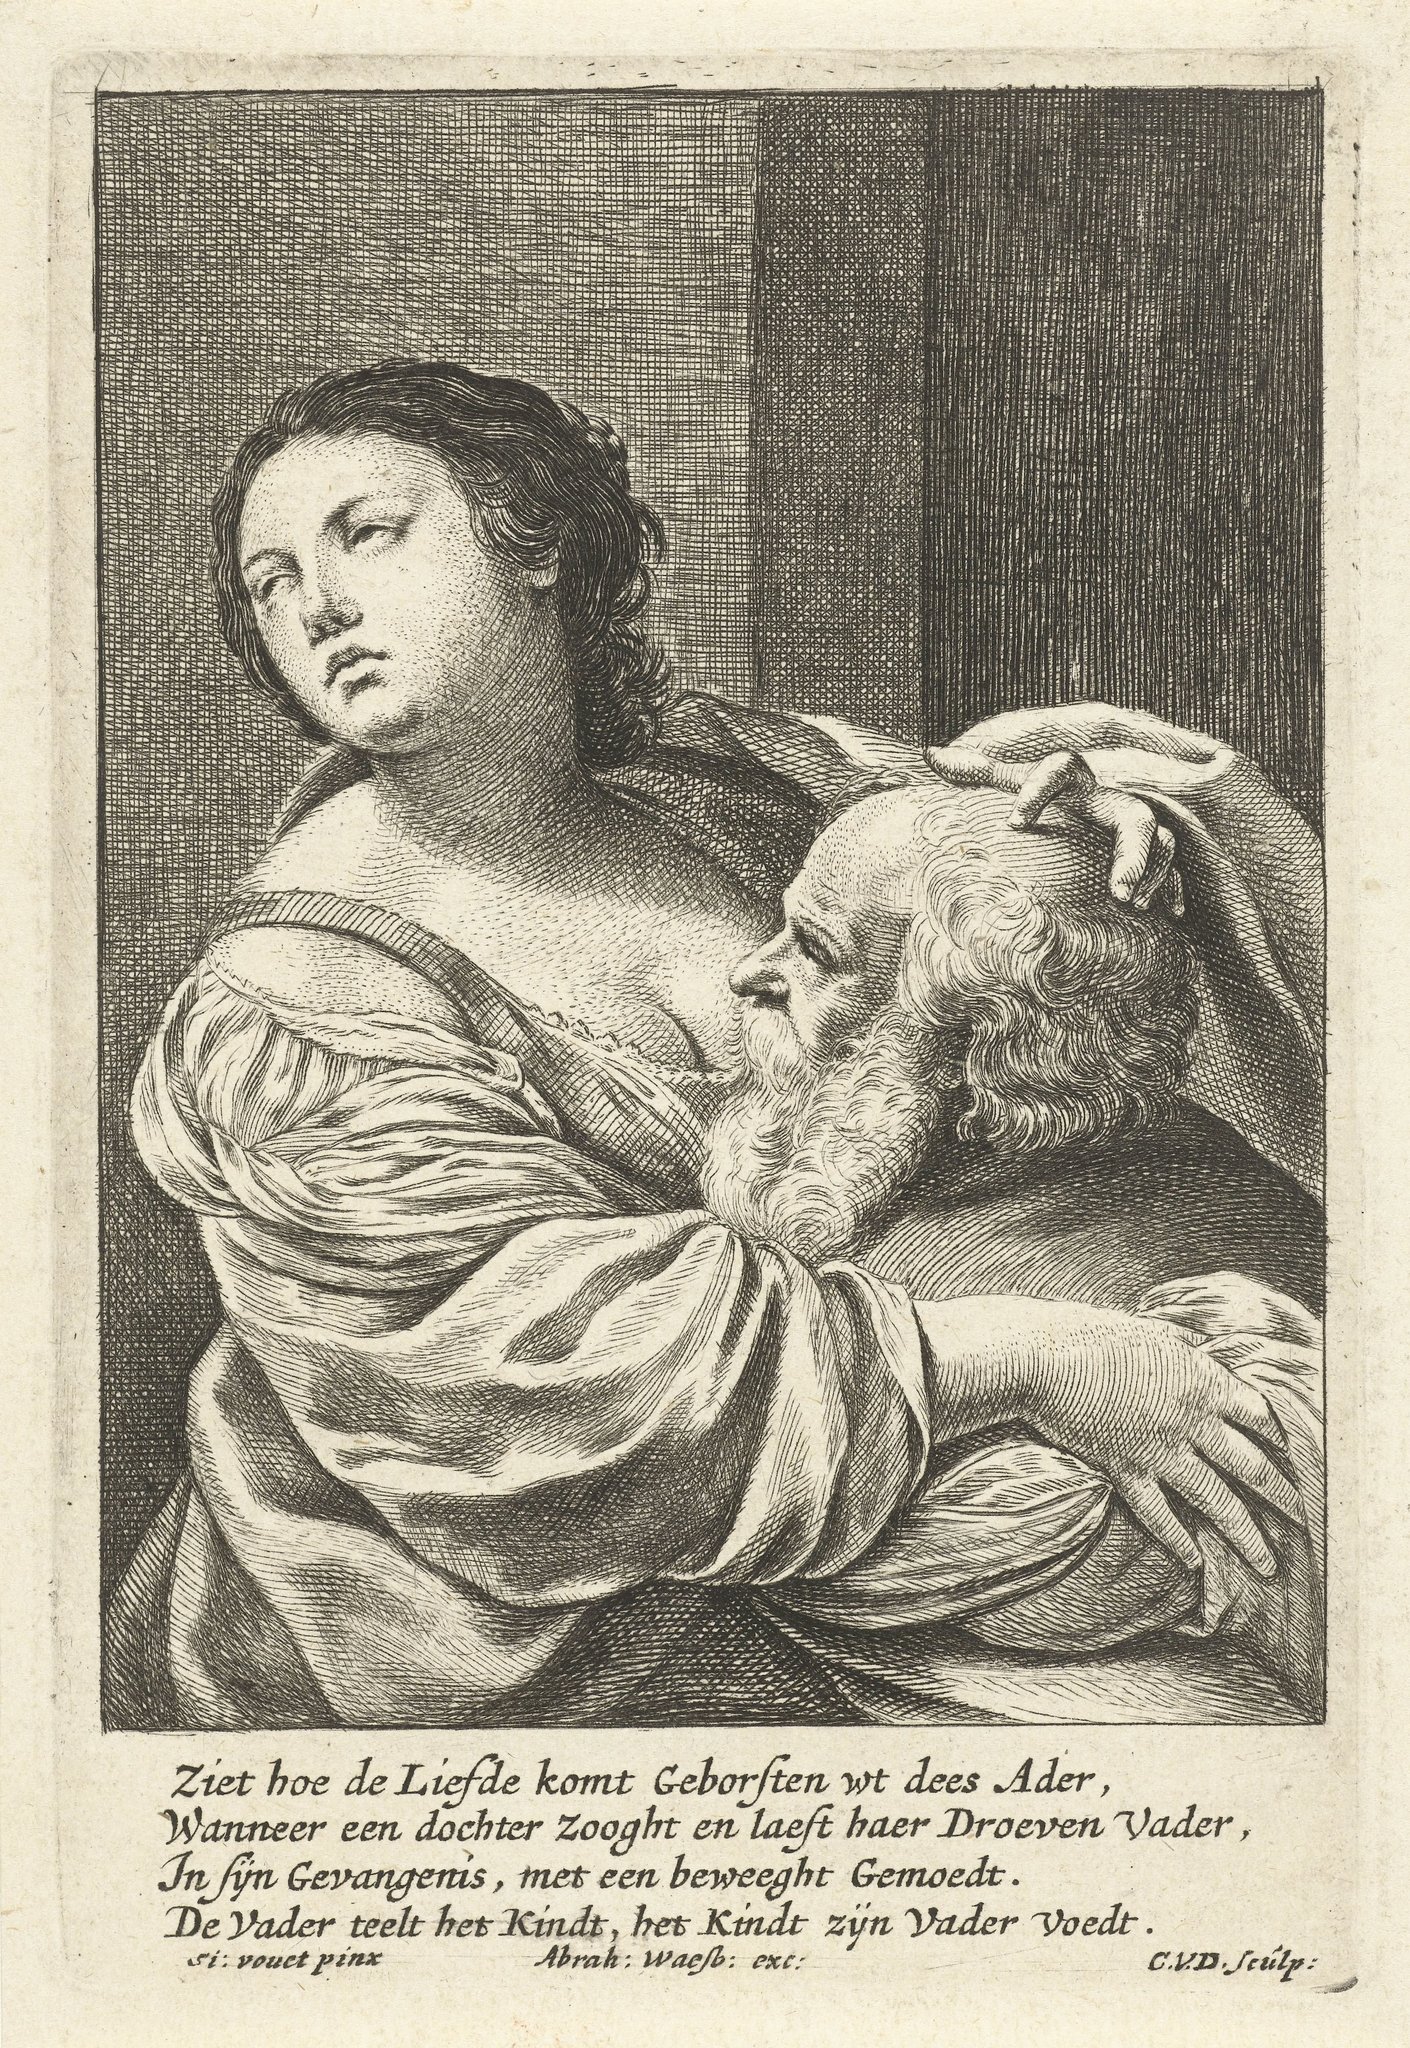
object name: print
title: Cimon drinkt aan de borst van zijn dochter Pero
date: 1612-1665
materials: paper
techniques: engraving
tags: pero suckling cimon ('caritas romana')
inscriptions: collector's mark: Lugt 240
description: Cimon drinkt aan de borst van zijn dochter Pero (Caritas Romana) in een gevangeniscel. In de ondermarge een Nederlands vers over dit verhaal uit de klassieke literatuur.